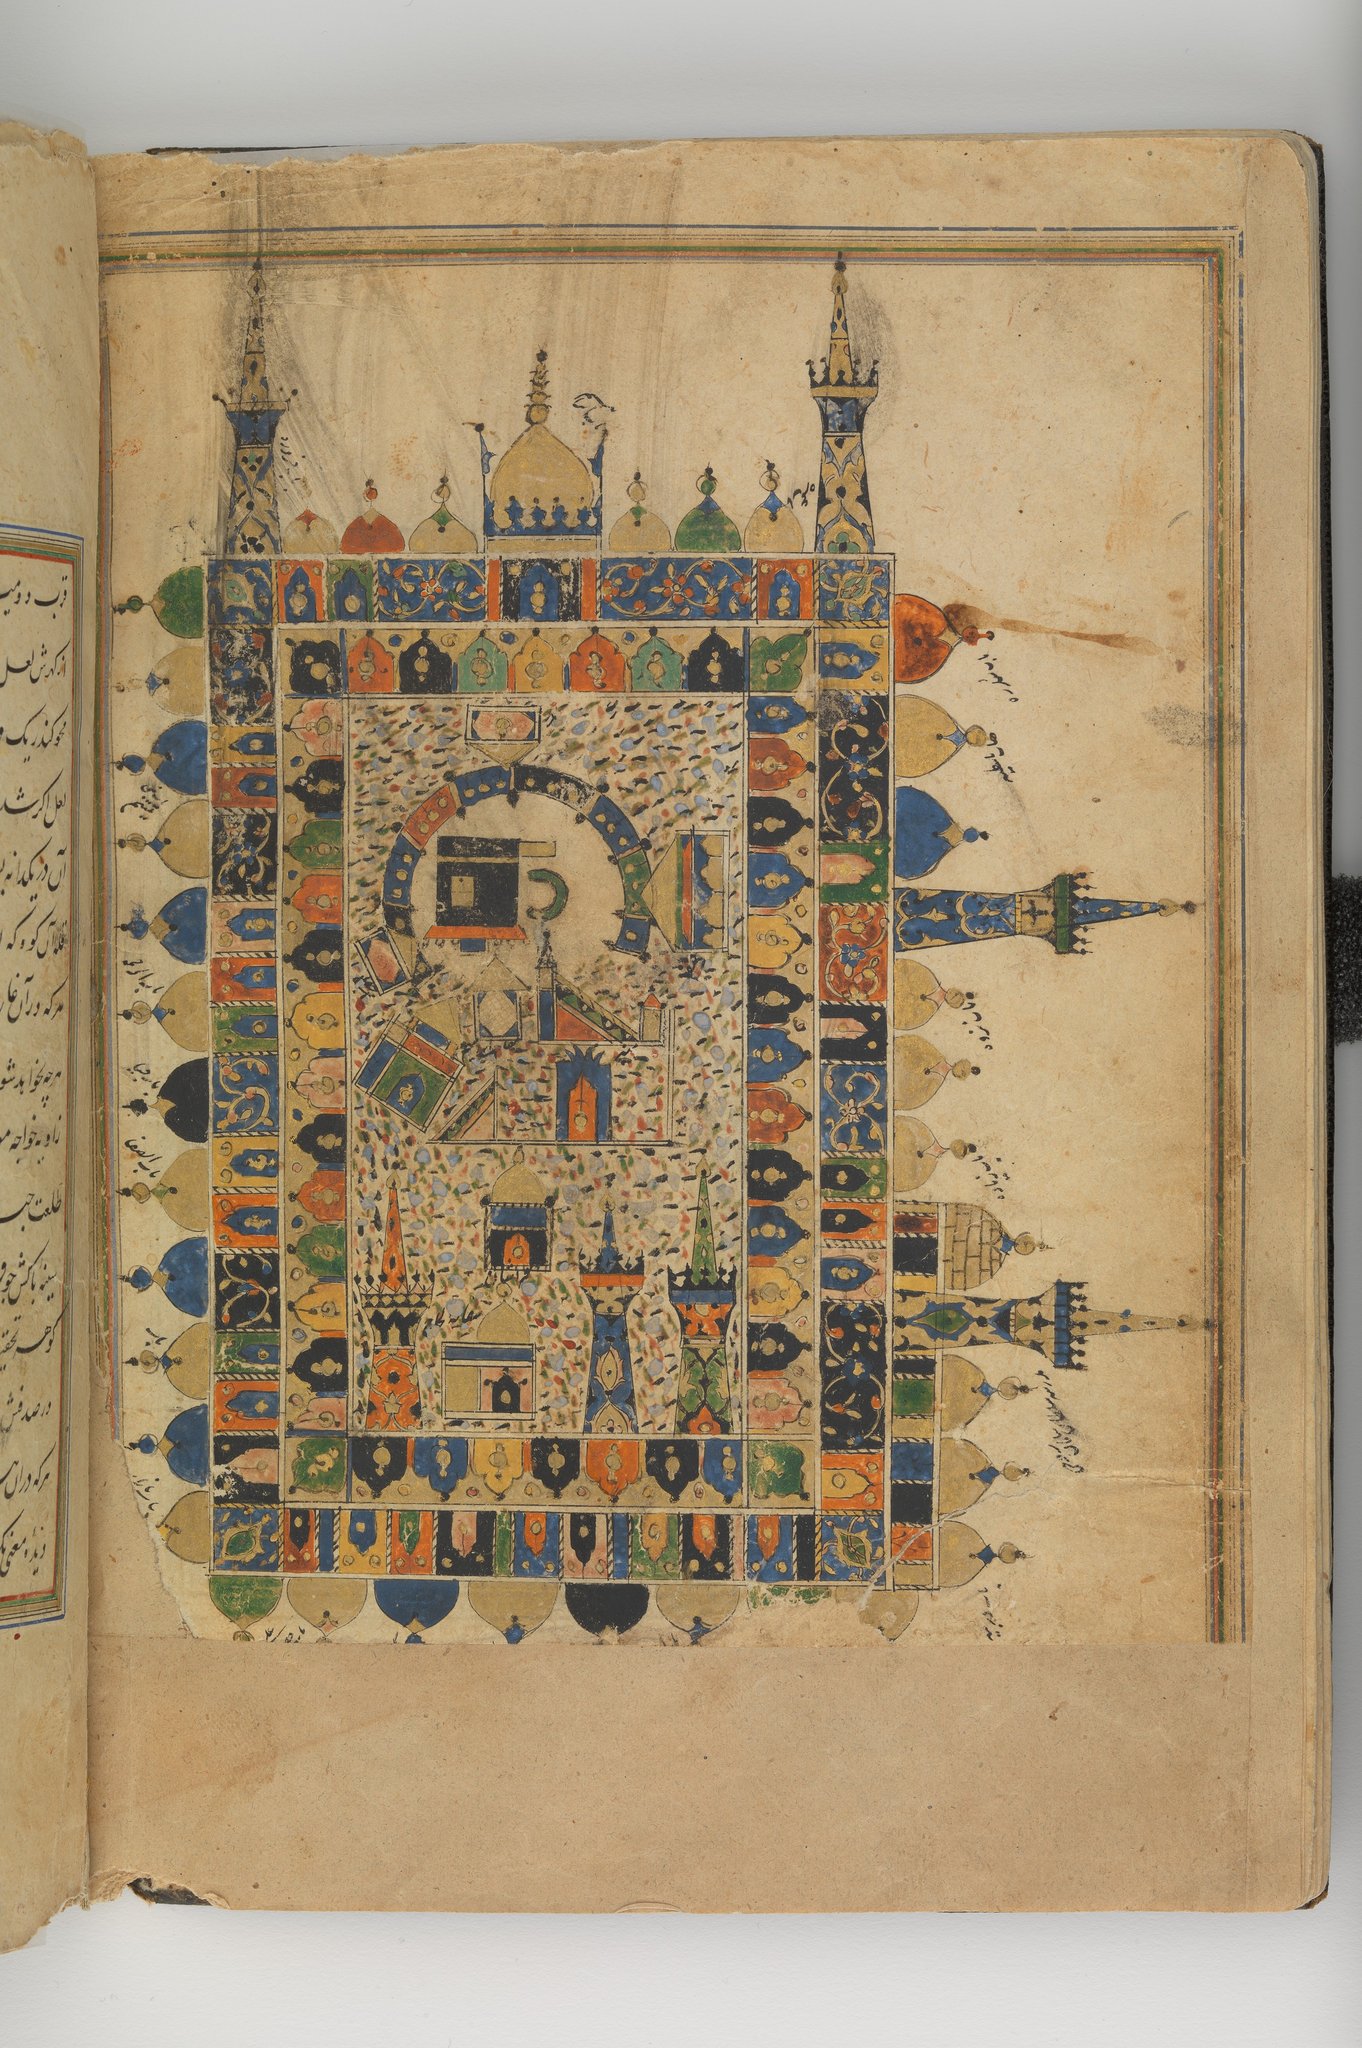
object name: illustrated manuscript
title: Futuh al-Haramayn (Description of the Holy Cities)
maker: muhi al-din lari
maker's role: author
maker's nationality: iranian or indian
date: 1501-1600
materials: gold, ink, paper, watercolor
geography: uzbekistan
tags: cities